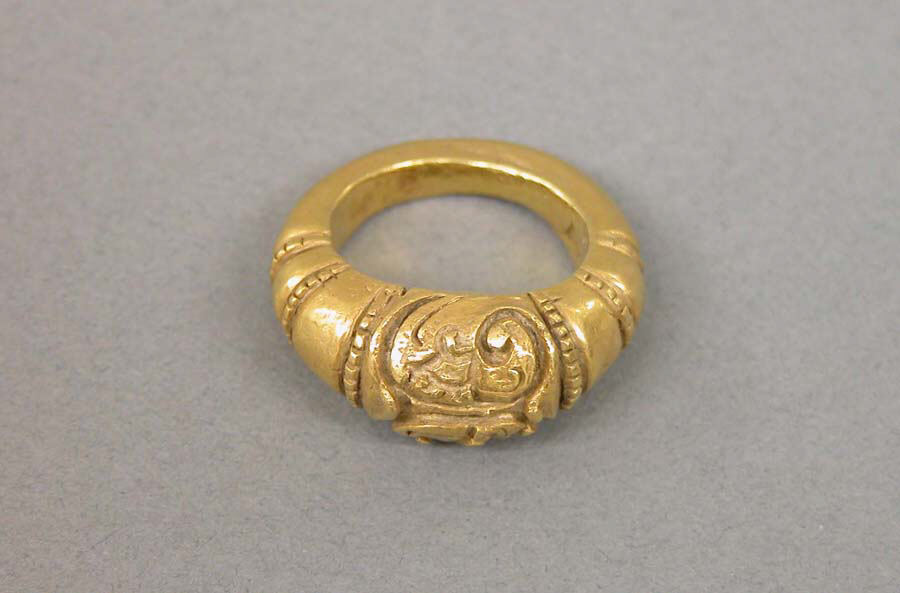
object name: ring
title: Ring with Foliate Scroll Pattern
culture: indonesian, javanese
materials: gold